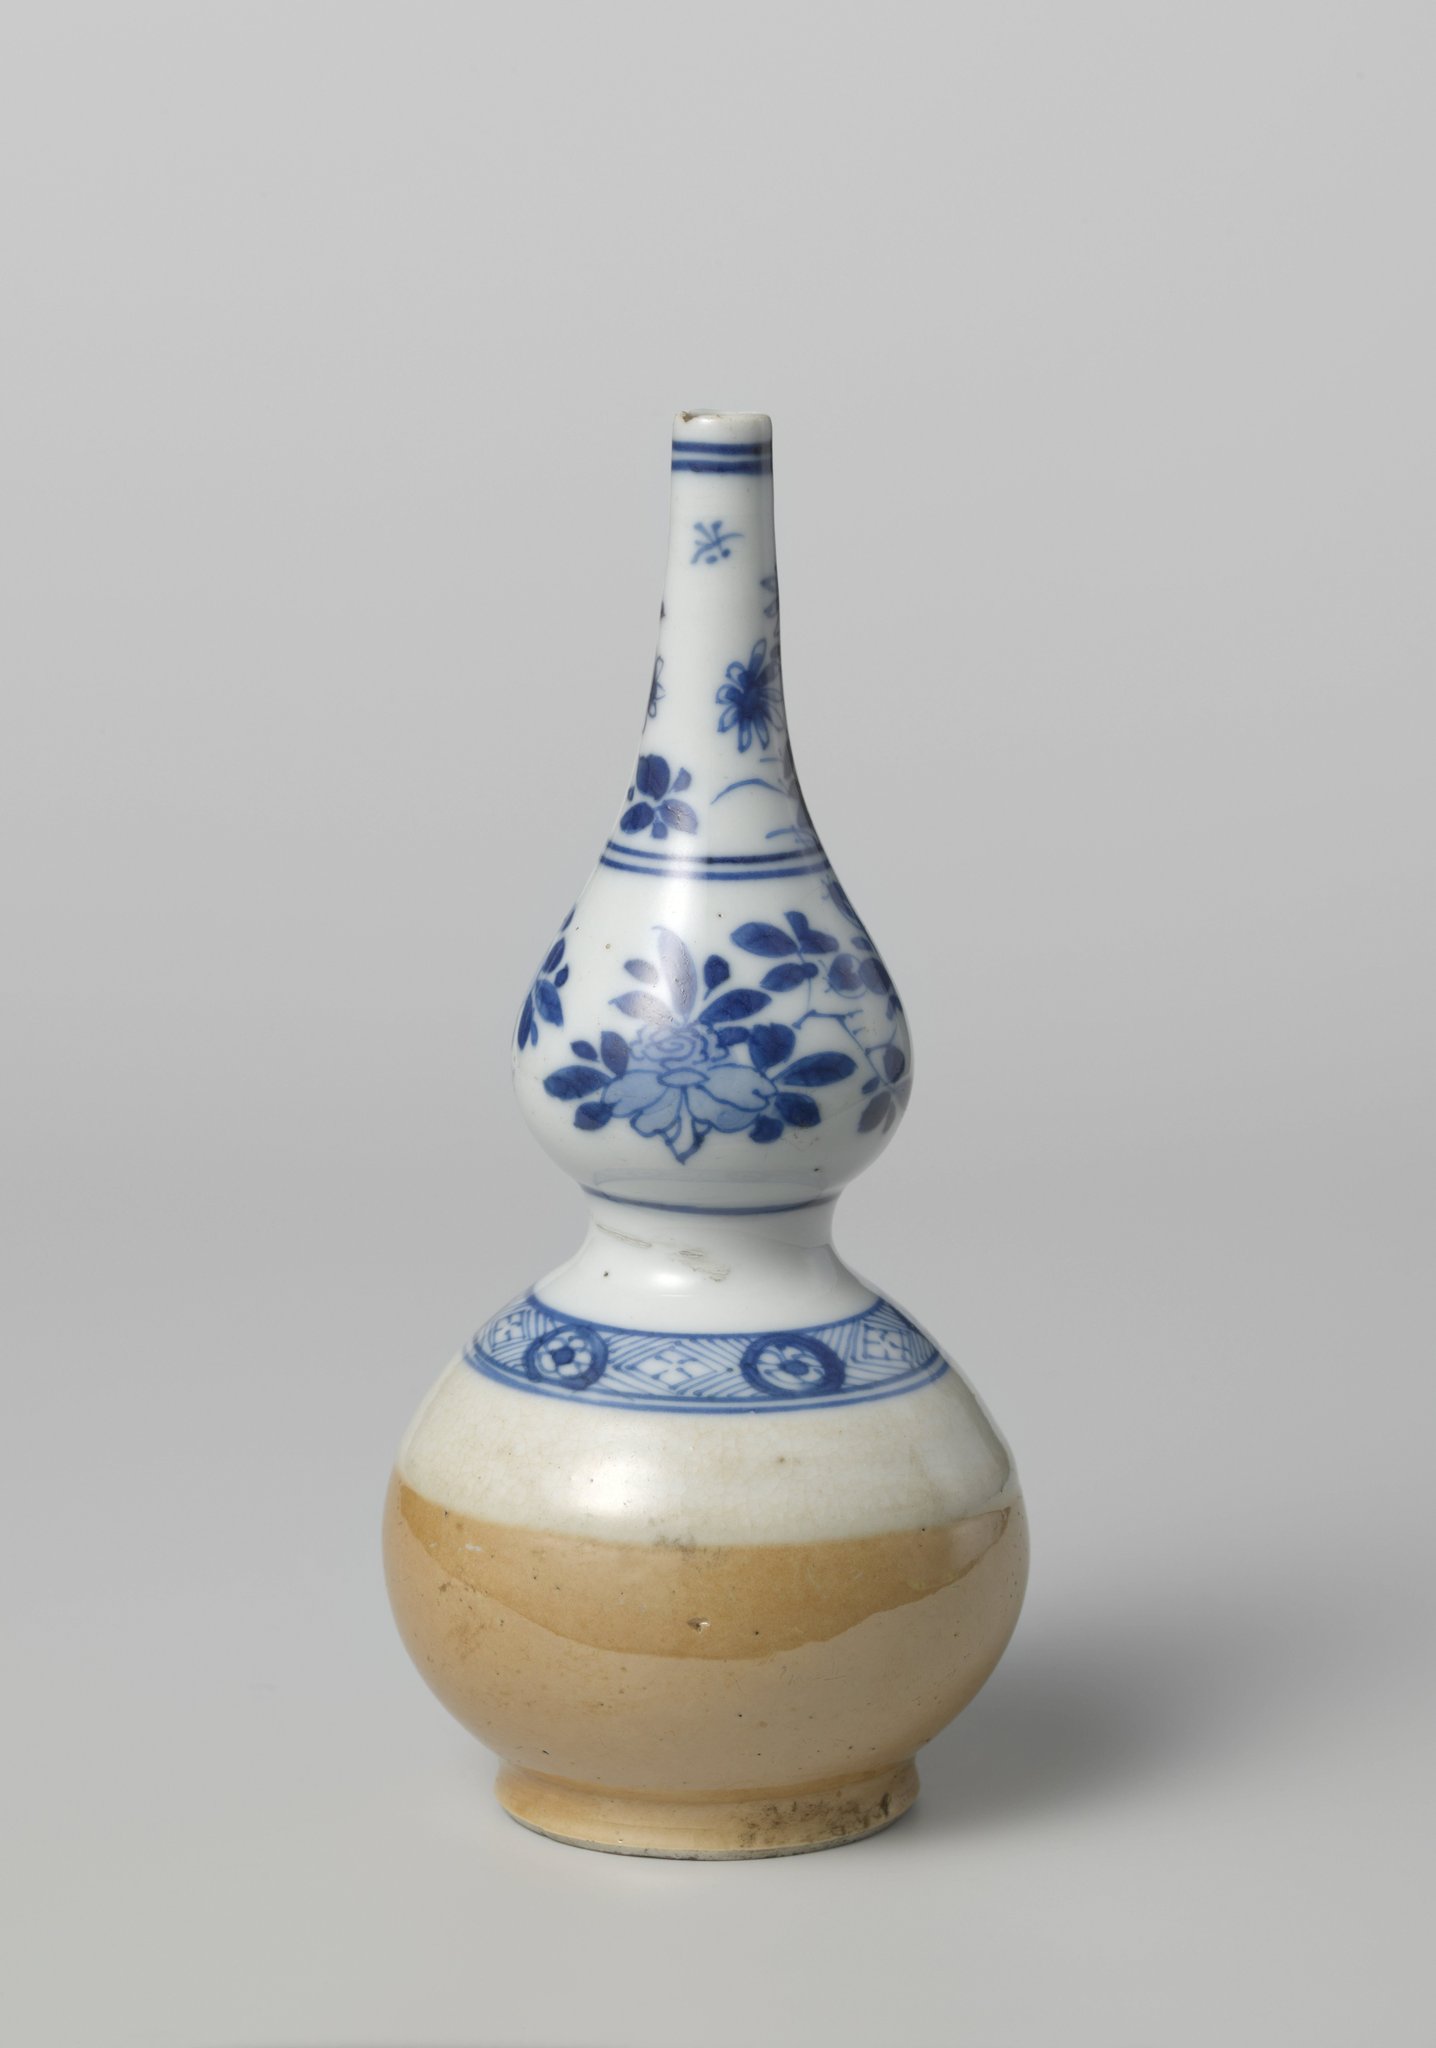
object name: bottle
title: Double gourd-shaped bottle vase with light brown and flower sprays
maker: Anonymous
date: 1700-1724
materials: cobalt, glaze, paint, porcelain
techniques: firing, turning, vitrification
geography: china